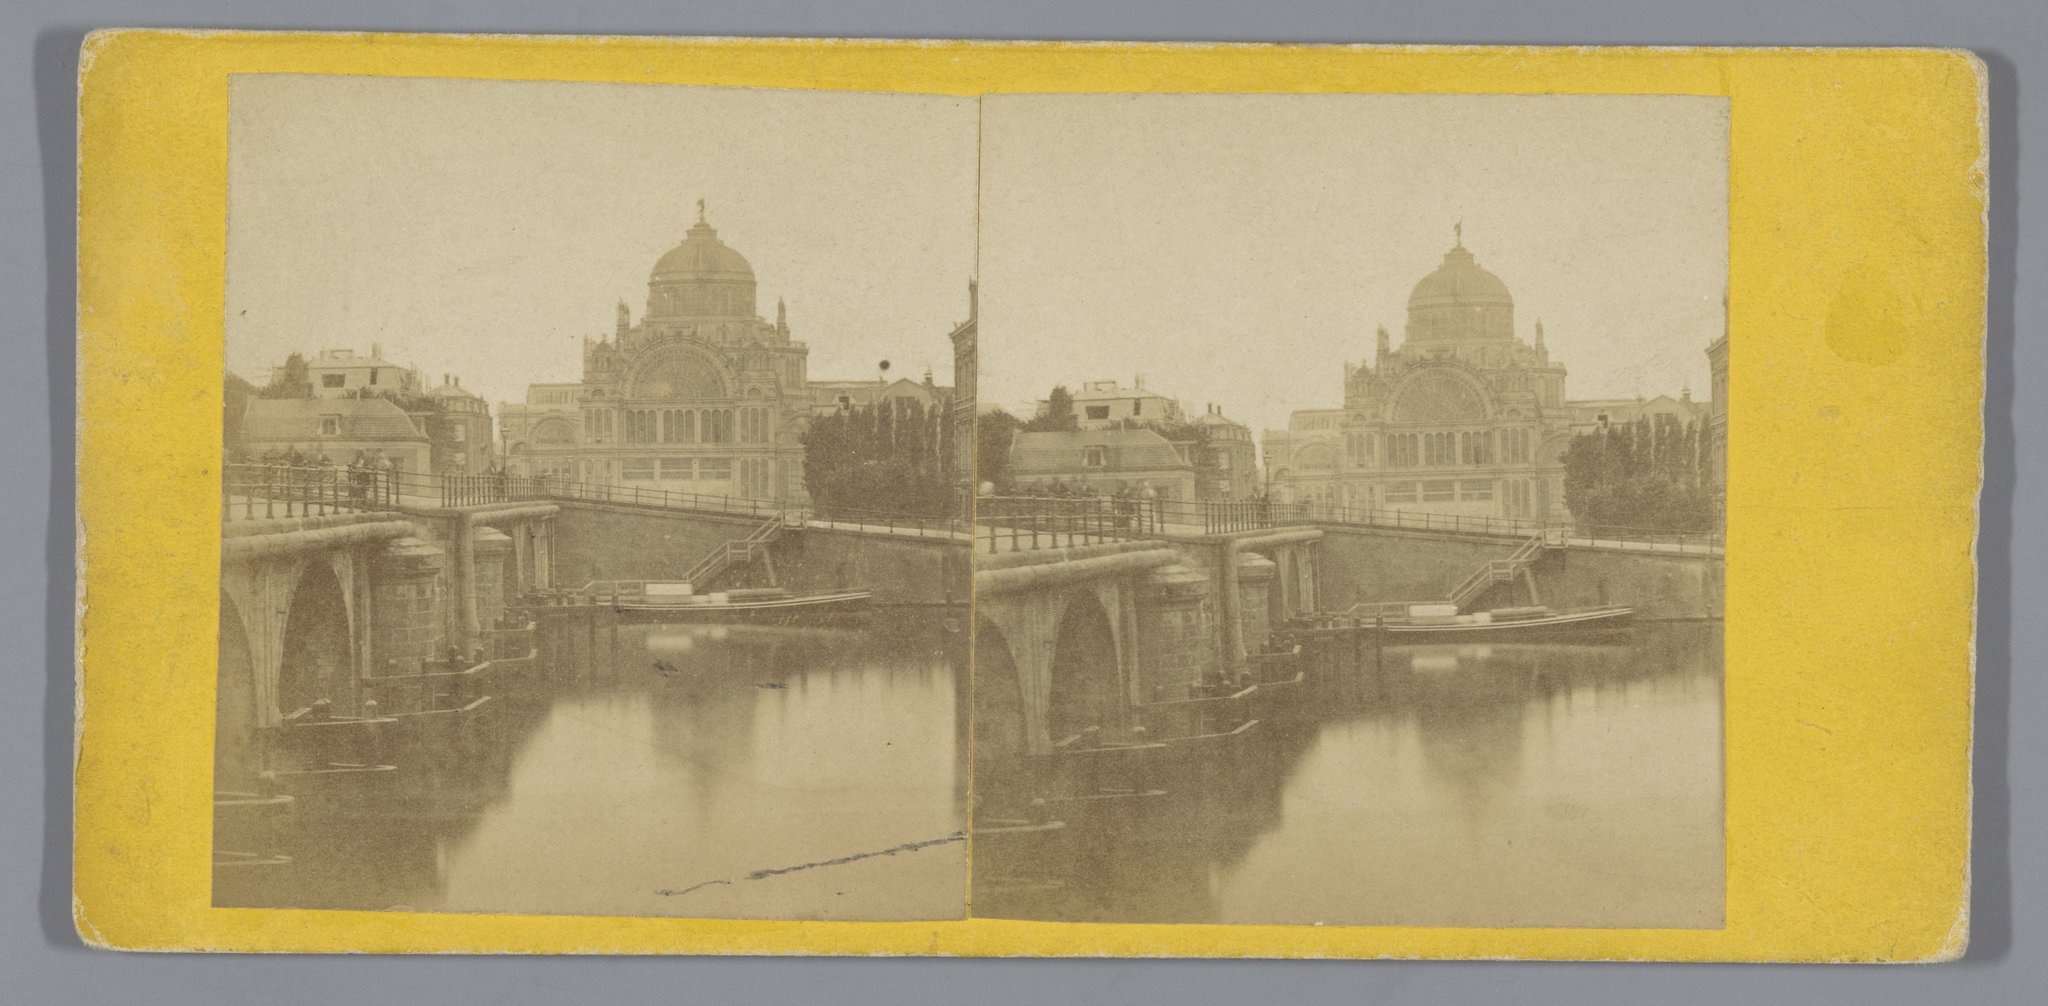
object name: stereograph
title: Paleis voor Volksvlijt, gezien vanaf de Amstel, Amsterdam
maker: Anonymous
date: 1864-1870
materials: cardboard, paper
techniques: albumen print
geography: amsterdam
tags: palace, bridge in city across river, canal, etc.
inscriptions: inscription: ‘Hollande/ Amsterdam, Palais de cristal’